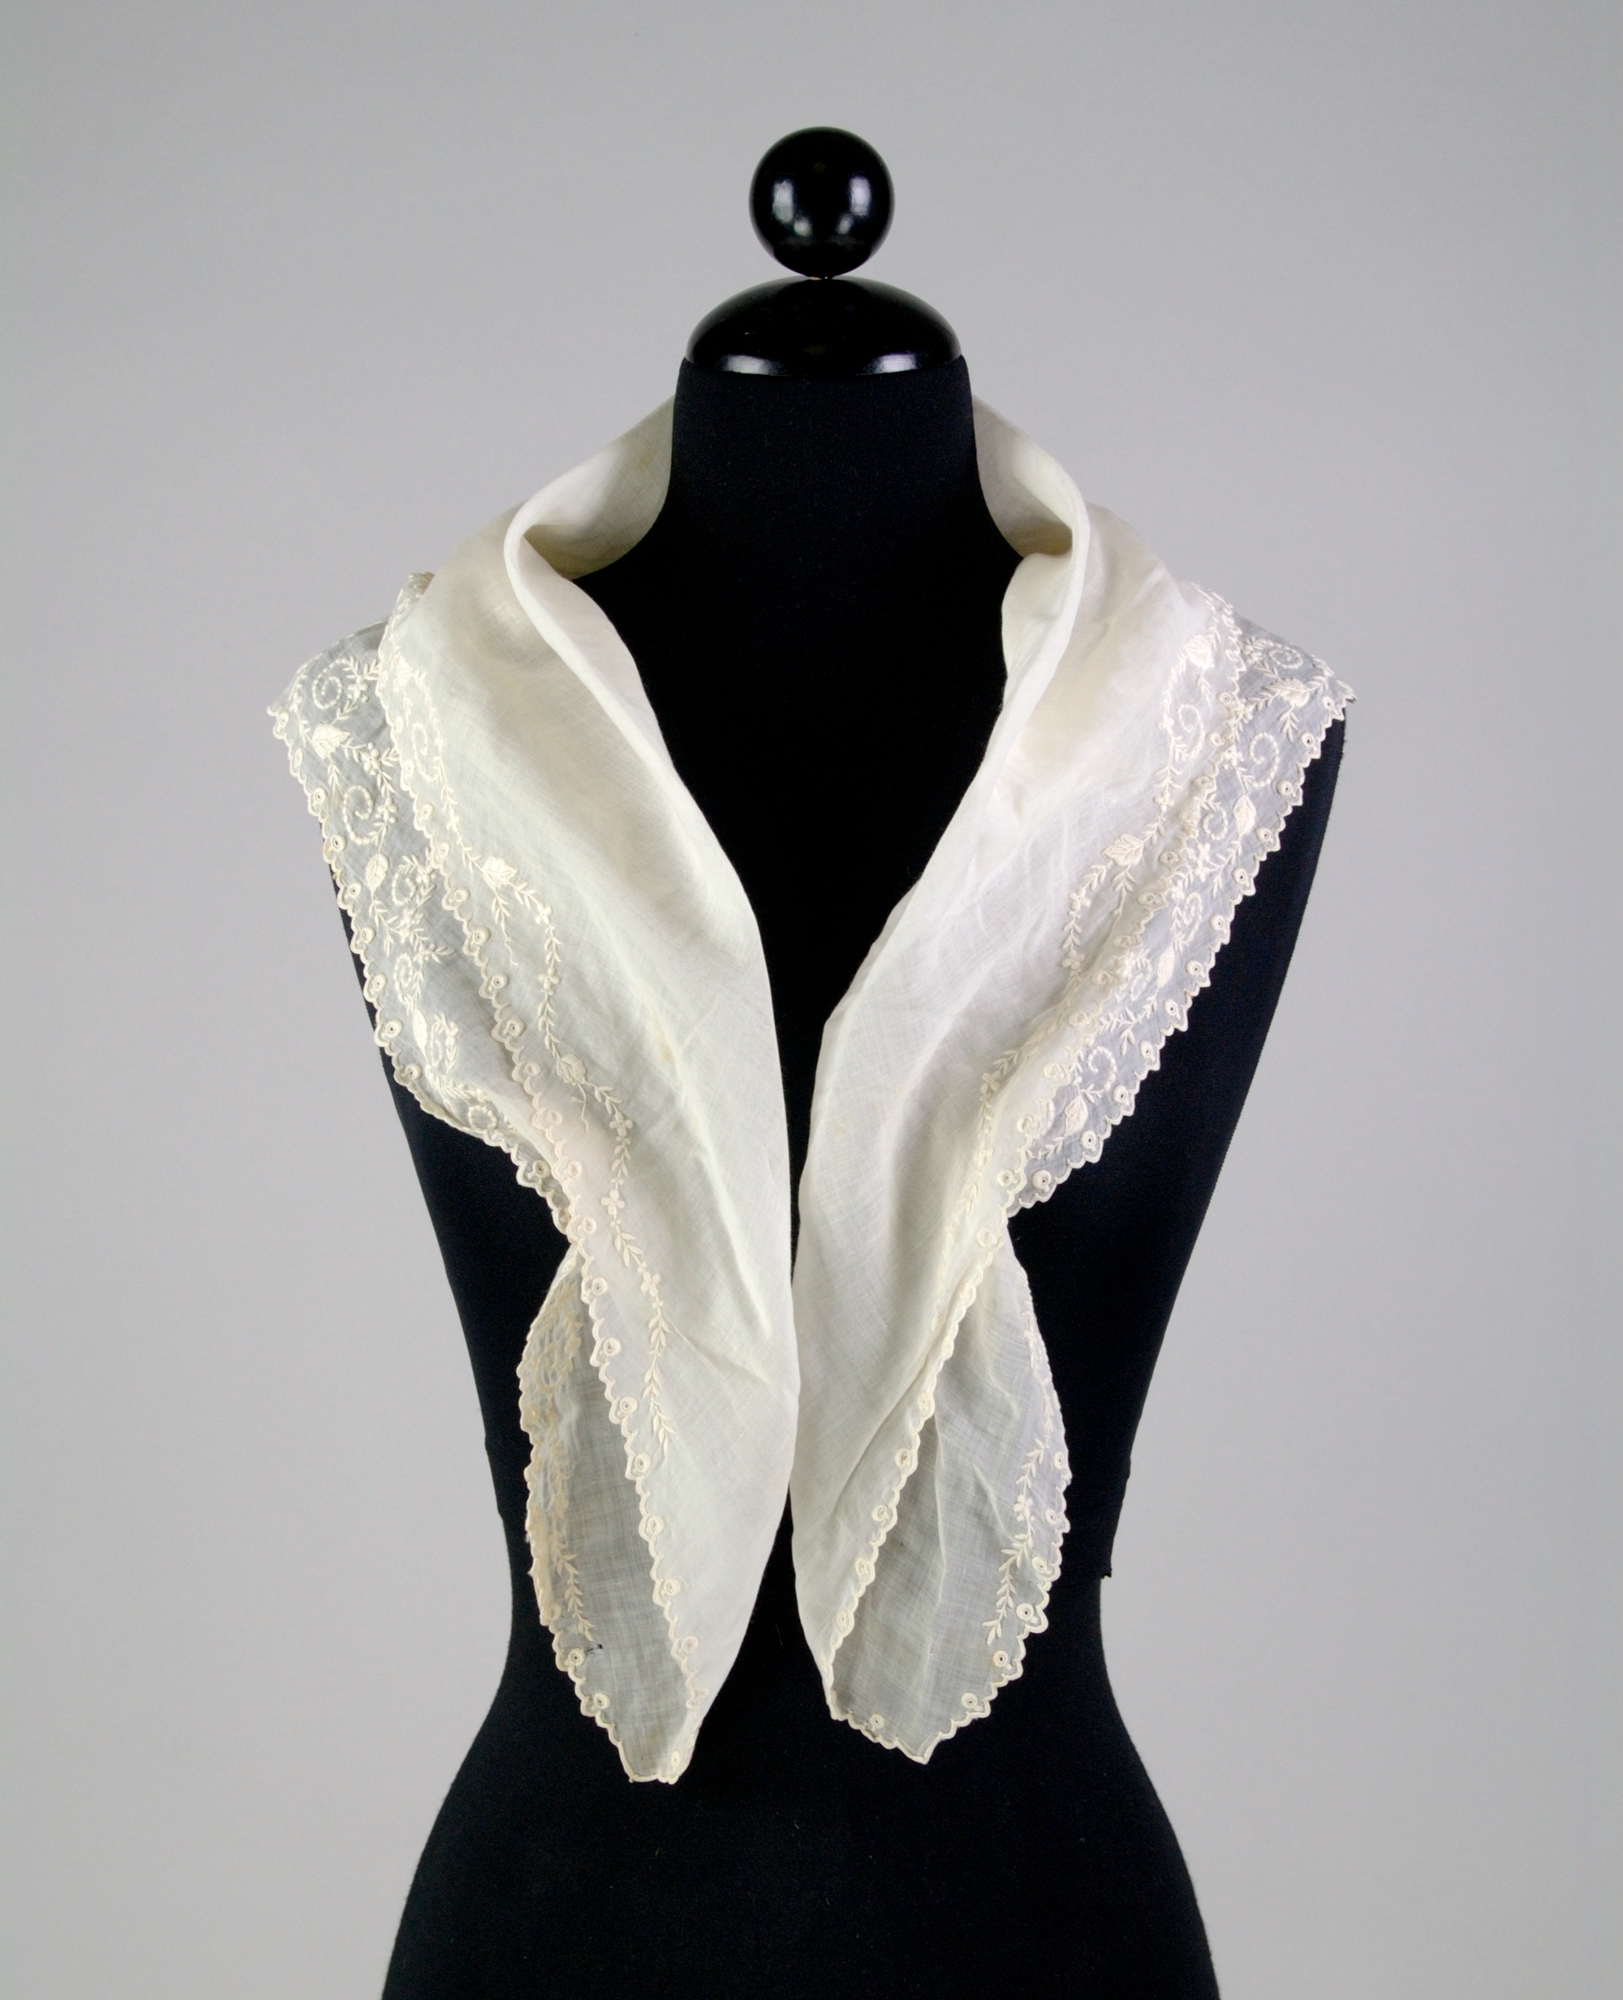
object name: fichu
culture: american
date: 1830-1840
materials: cotton